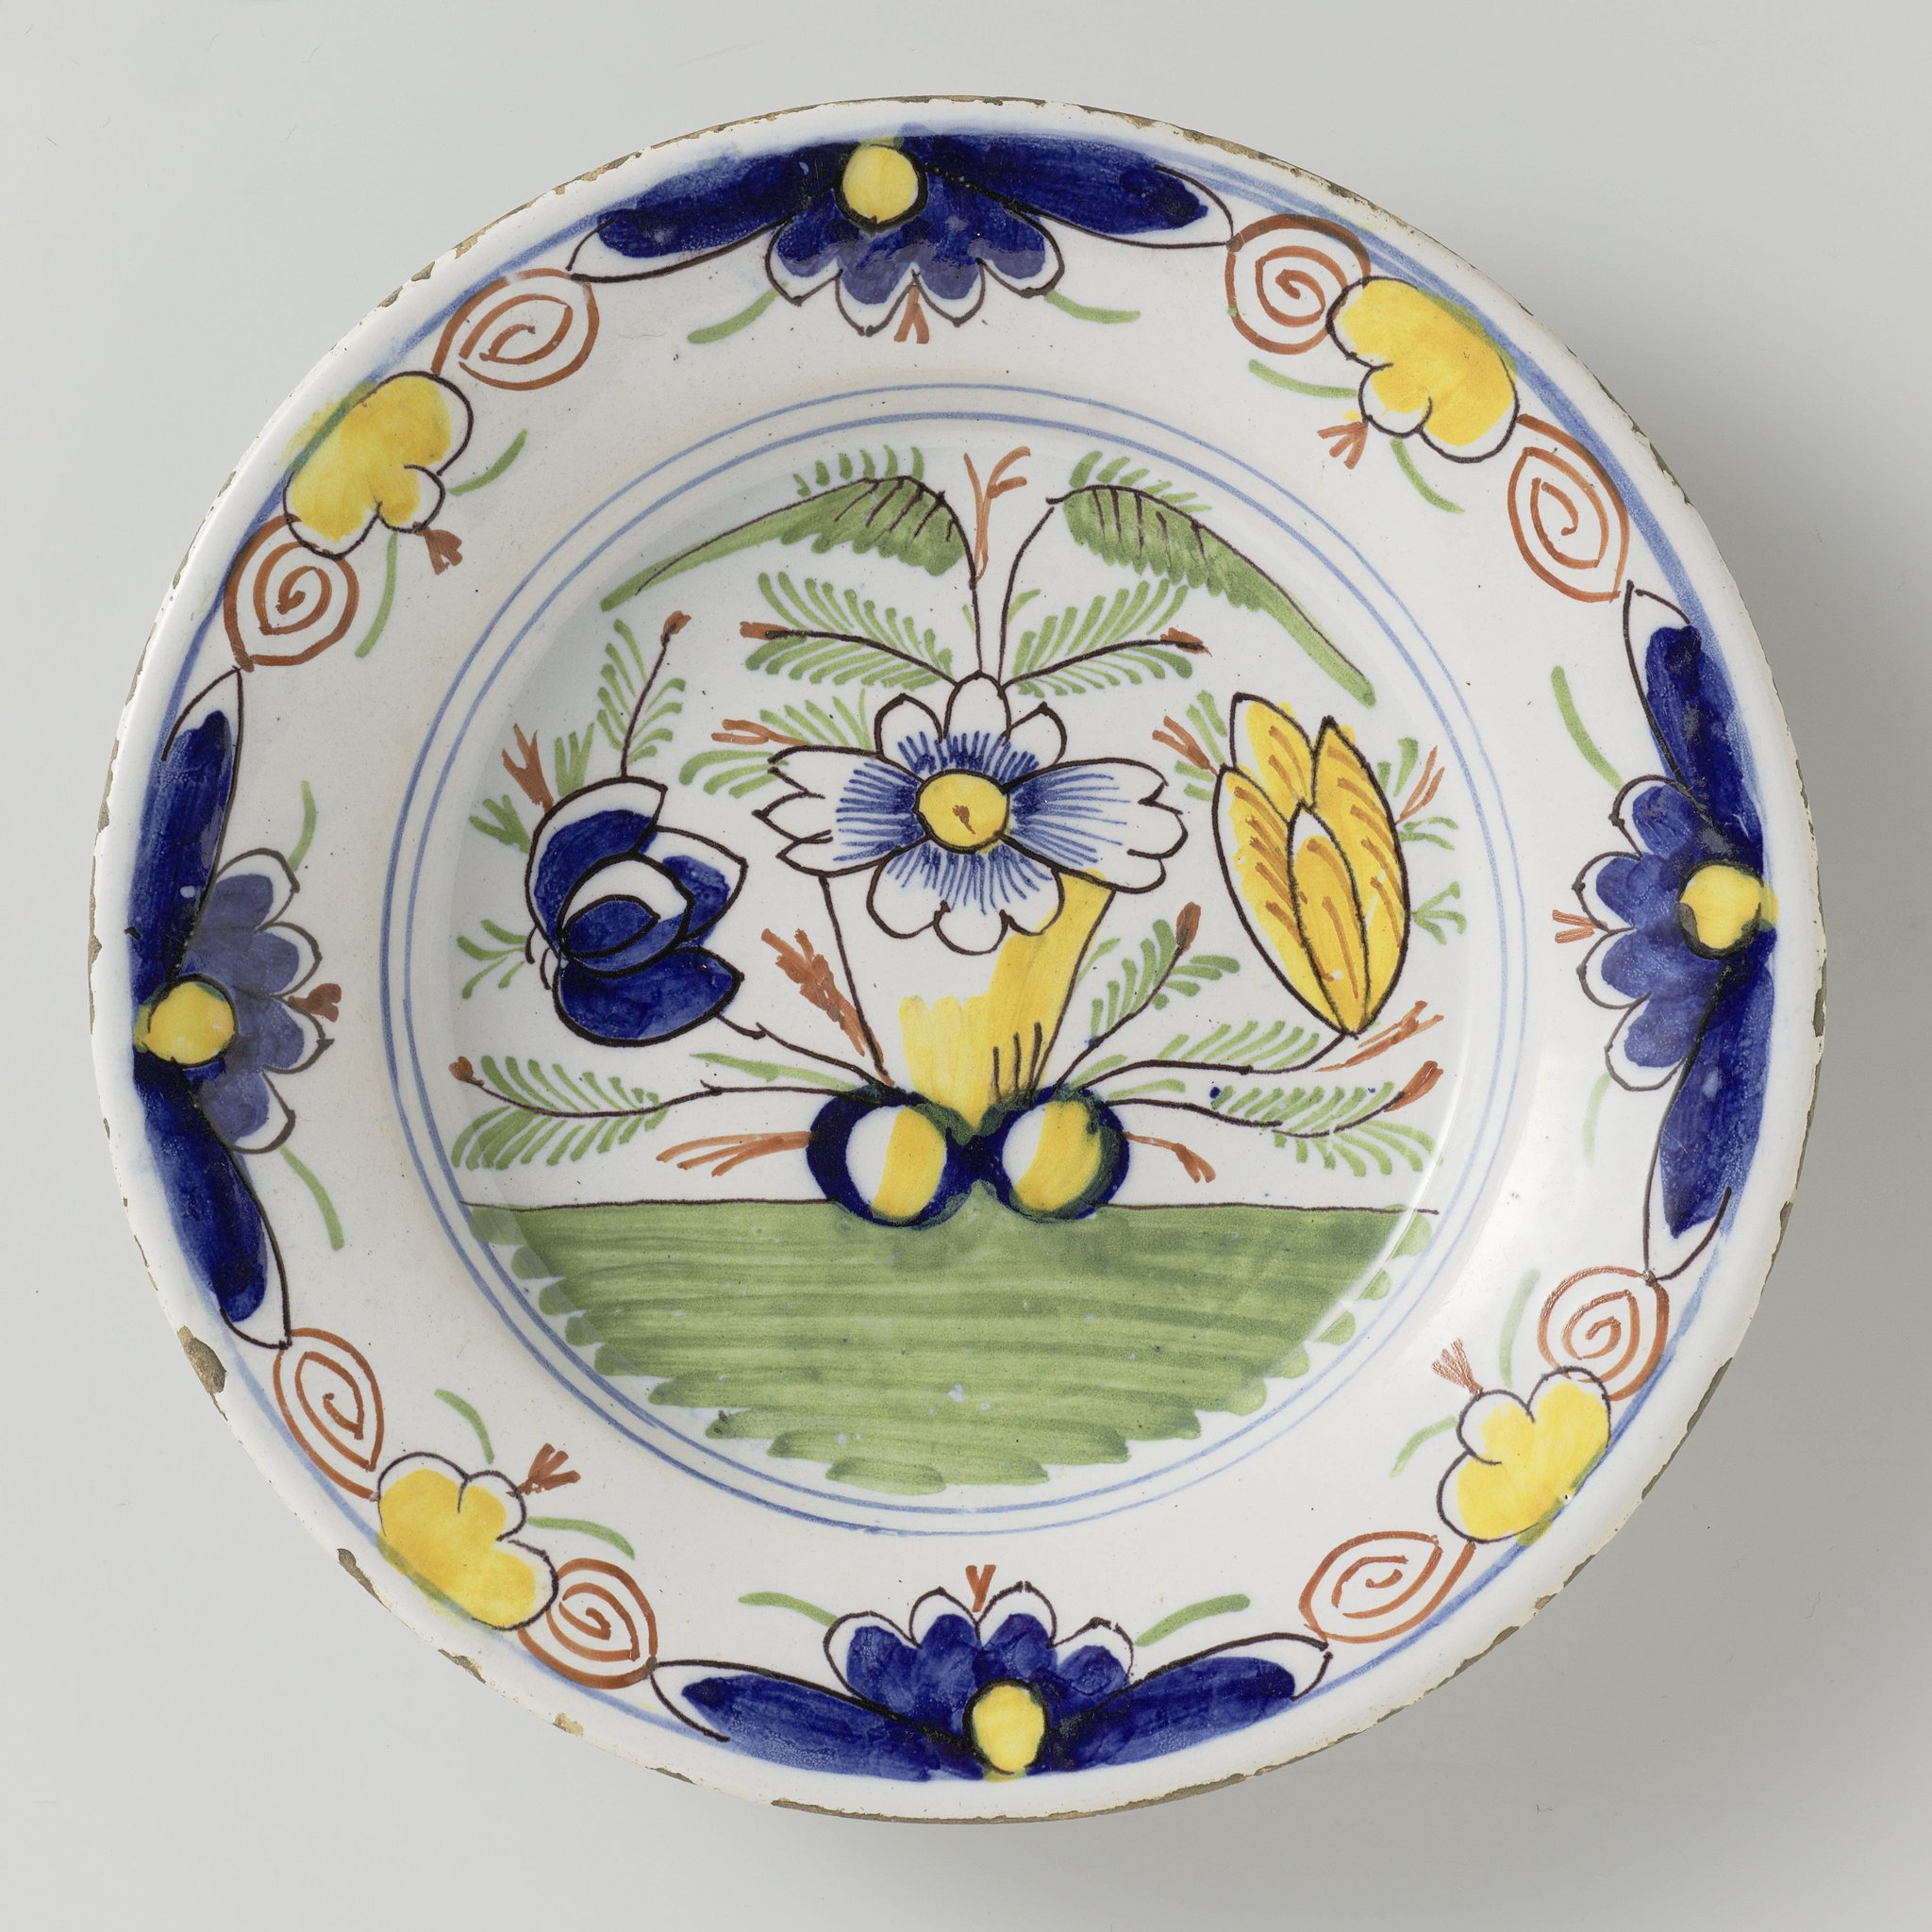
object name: plate dish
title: Bord van veelkleurig beschilderde faience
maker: Anonymous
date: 1750-1790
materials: faience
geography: delft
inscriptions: seal: ‘2712/ 3810’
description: Bord van veelkleurig beschilderde faience, versierd met bloemen in blauw, geel, groen, rood en paars op witte grond.